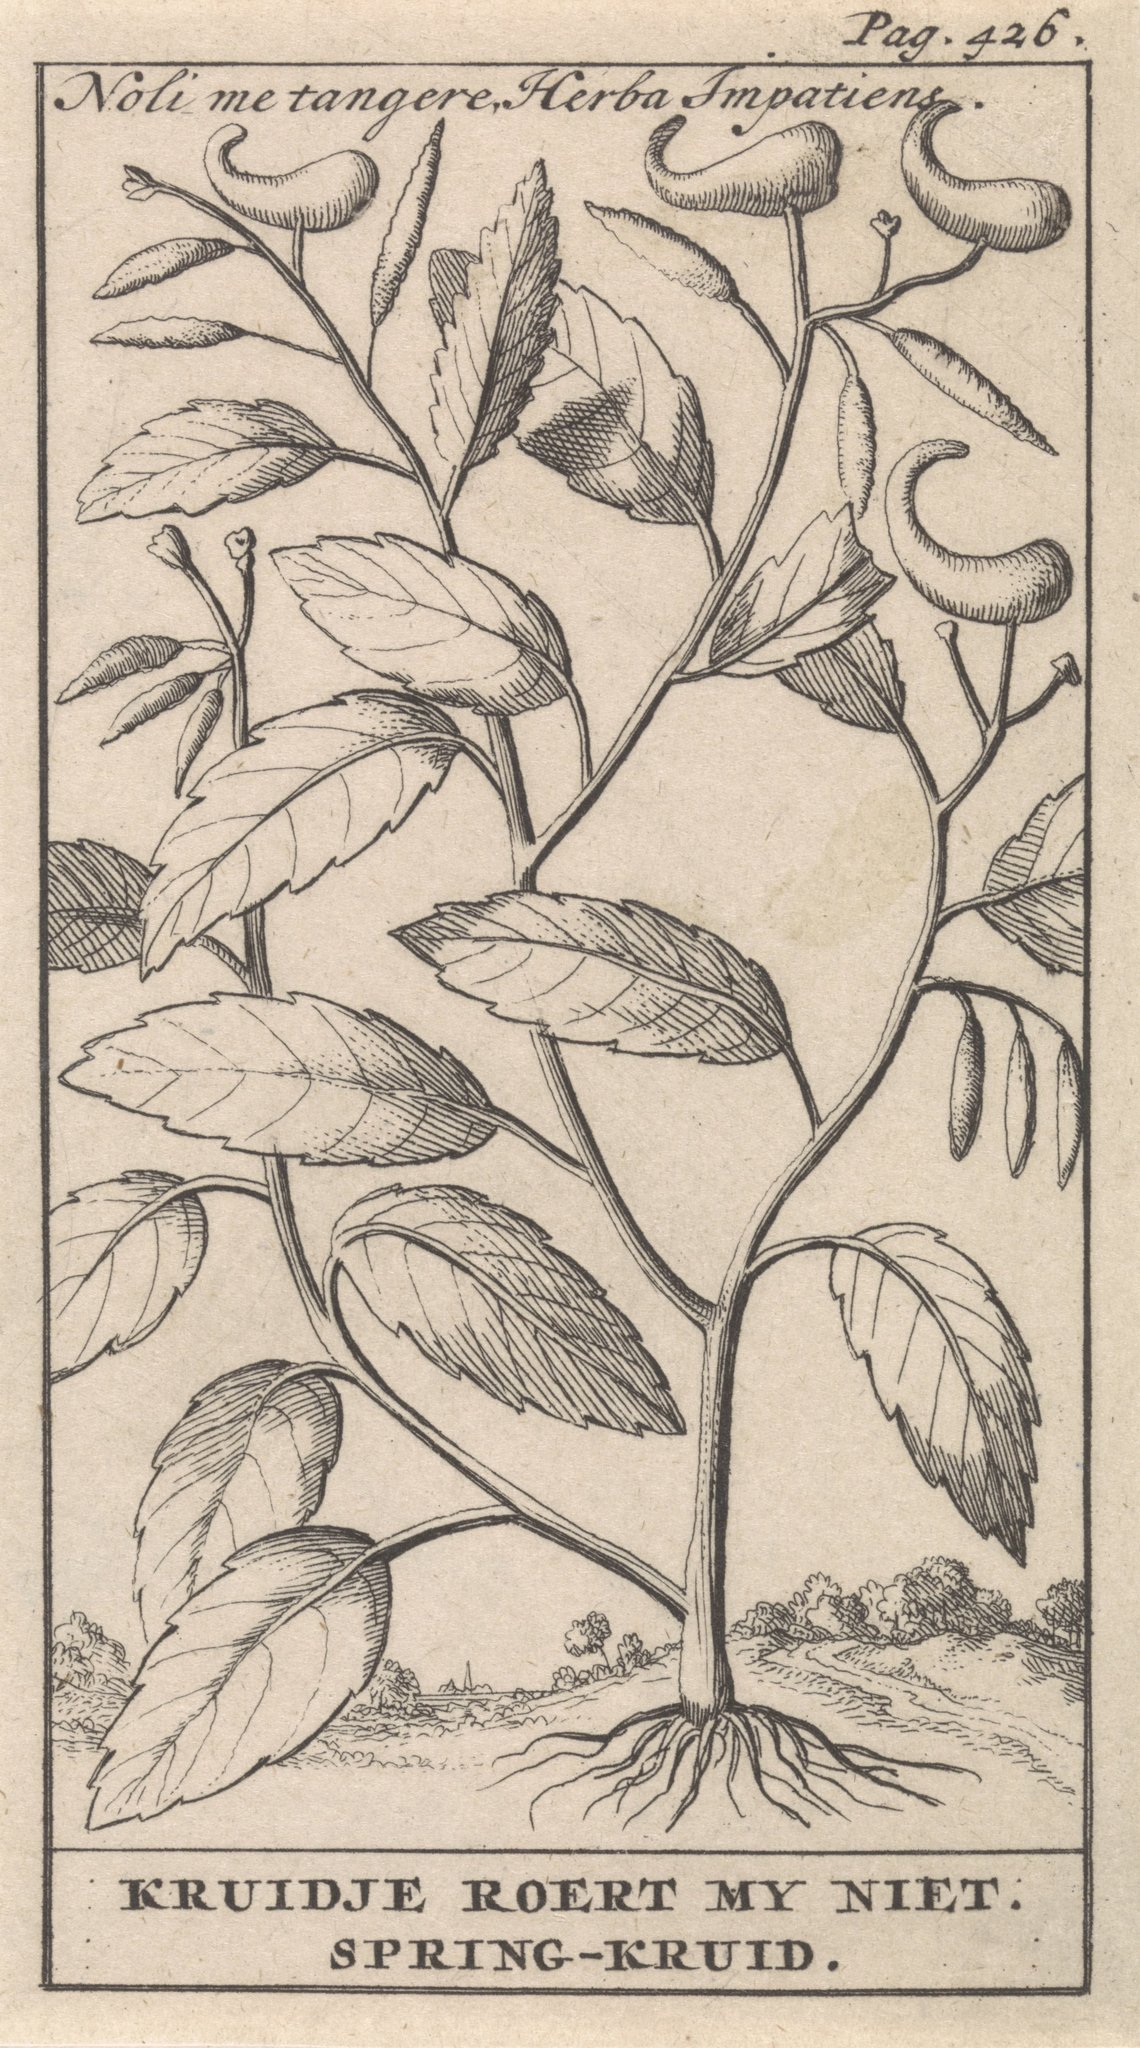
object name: print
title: Springkruid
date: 1698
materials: paper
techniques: etching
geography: amsterdam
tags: plants and herbs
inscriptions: collector's mark: Lugt 2228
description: Illustratie uit: Blankaart, Steven. Den Neder-landschen herbarius ofte Kruid-boek der voornaamste kruiden. Amsterdam: Jan Claesz ten Hoorn, 1698.